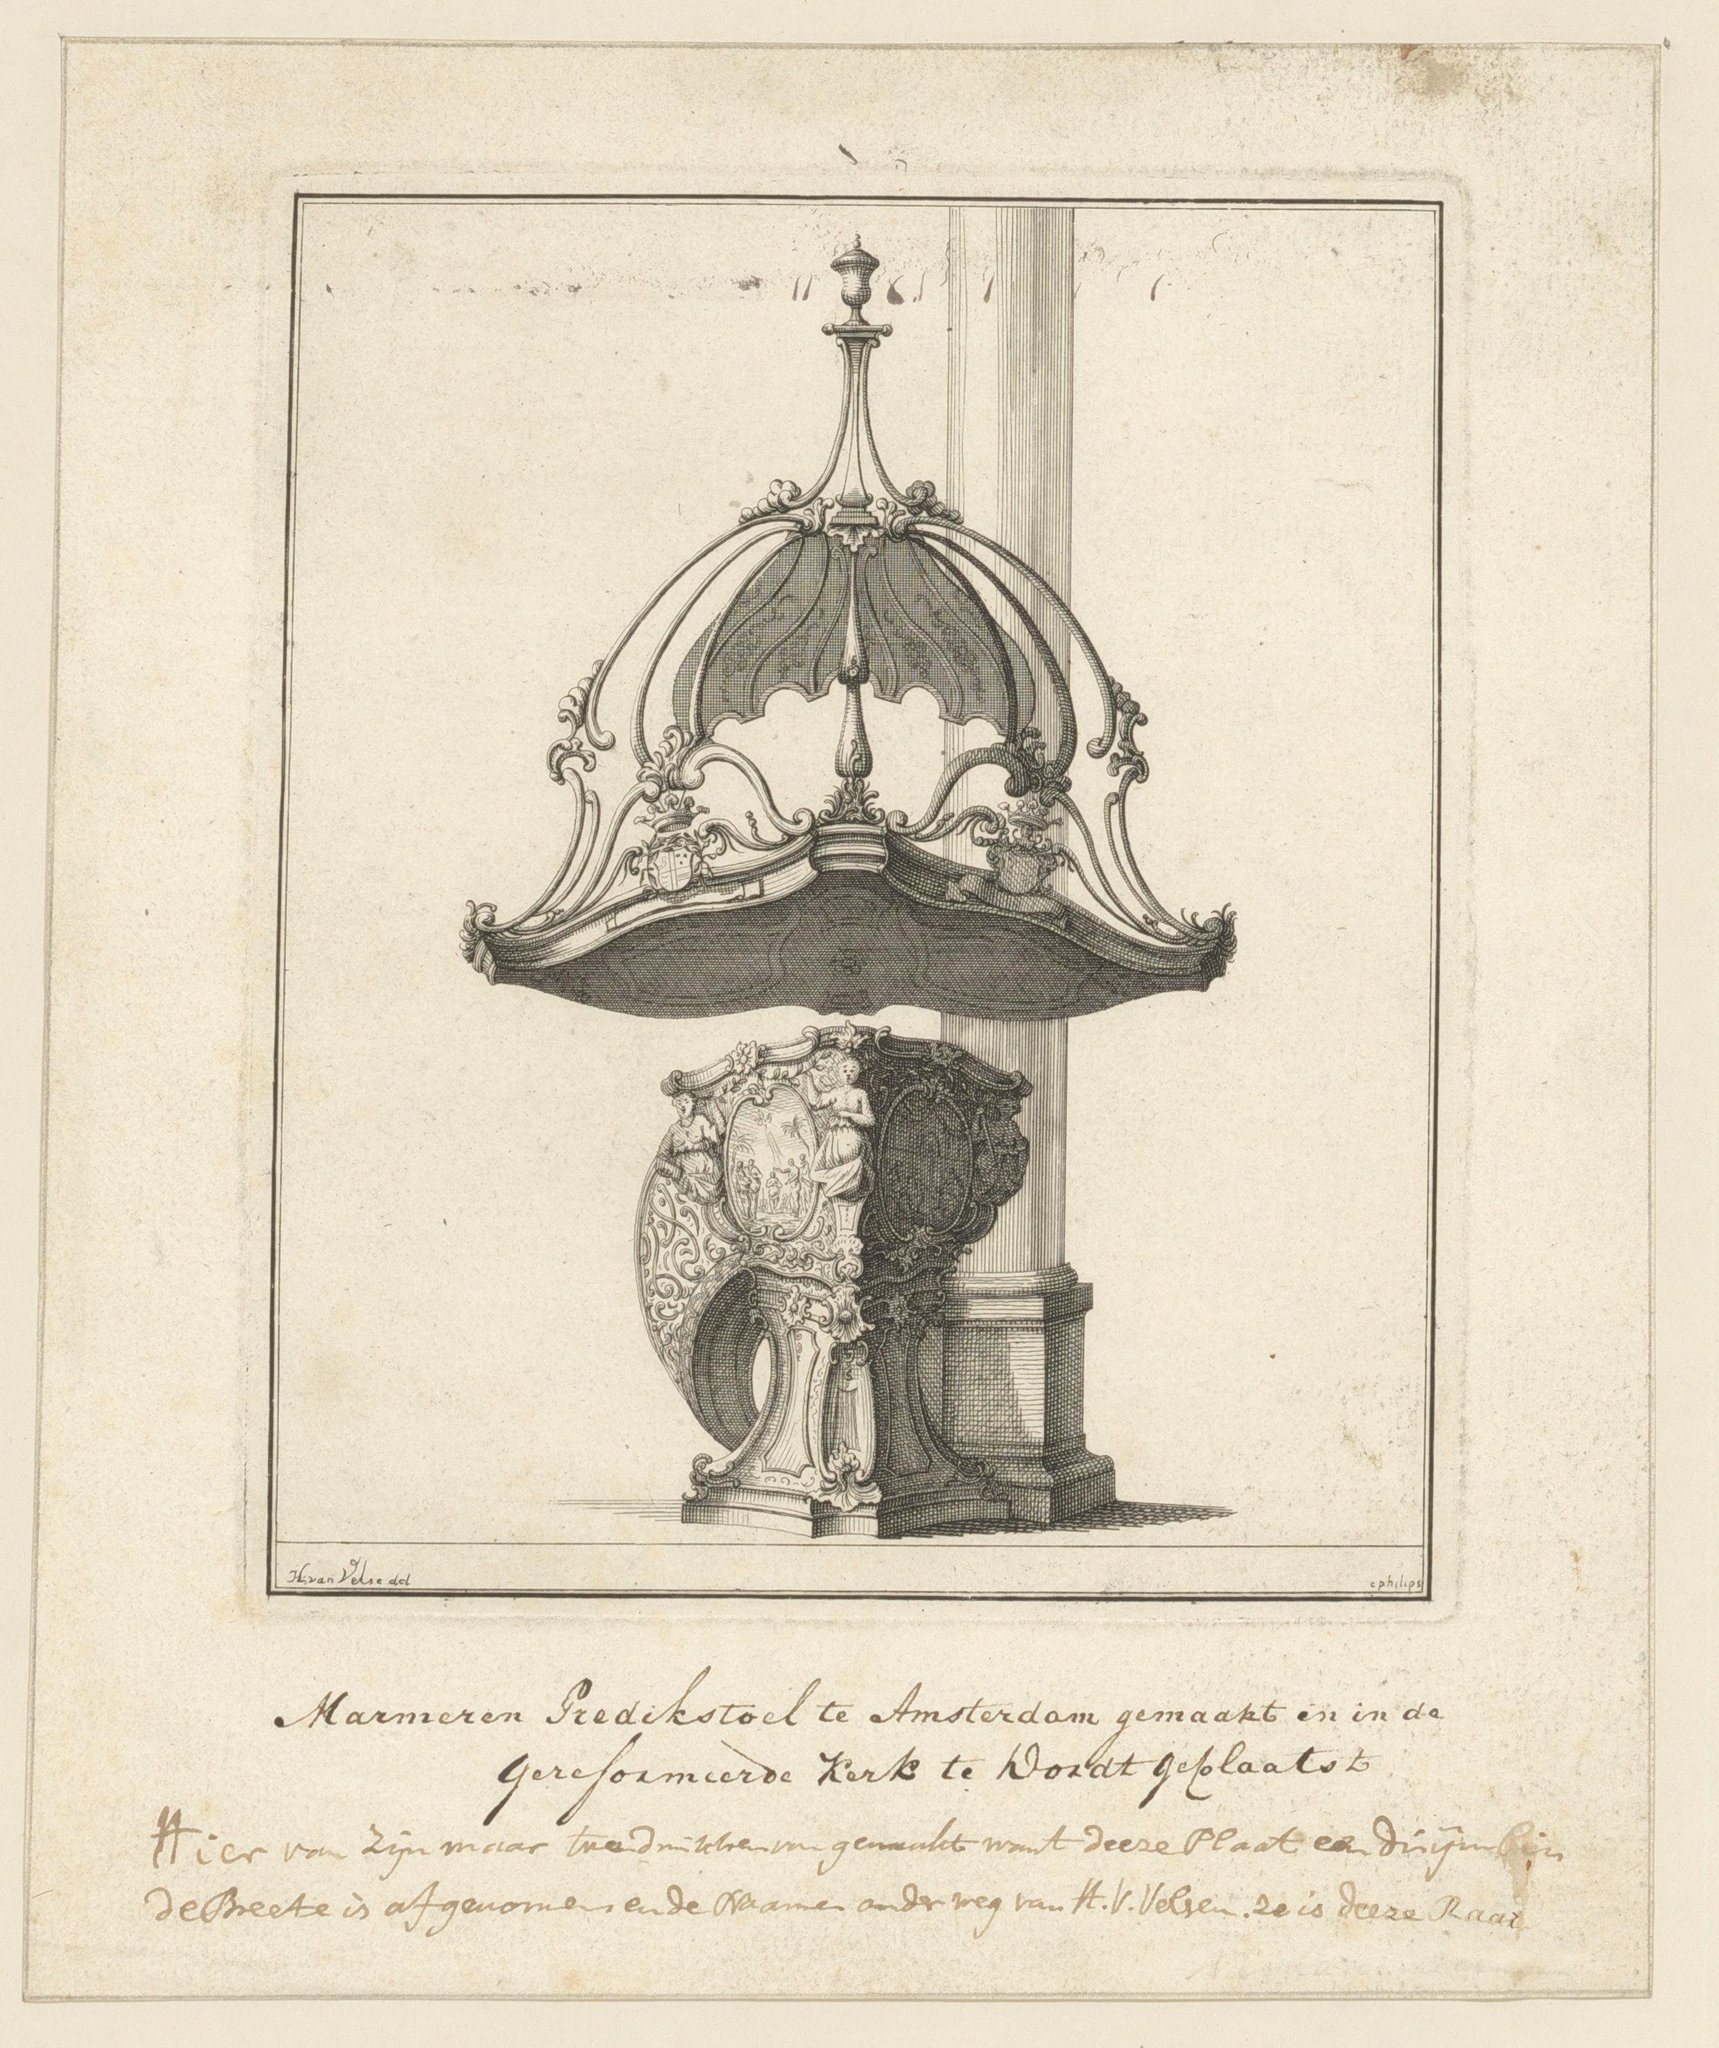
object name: print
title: Marmeren preekstoel in de Grote Kerk te Dordrecht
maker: caspar jacobsz. philips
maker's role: draughtsman, print maker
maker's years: 1732-1789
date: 1750-1756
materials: paper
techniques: engraving, etching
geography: netherlands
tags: pulpit, ambo, chancel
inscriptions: collector's mark: Lugt 1641, collector's mark, inscription:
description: De marmeren preekstoel gemaakt te Amsterdam voor de Grote Kerk te Dordrecht. Eerste onafgesneden staat met de namen van de makers. Onderwerpsrubrieken binnen de Atlas Zeden en Gewoonten: Kerk en kerkwezen & Armwezen en liefdadige instellingen; Kerkgebouwen elders. A-E.